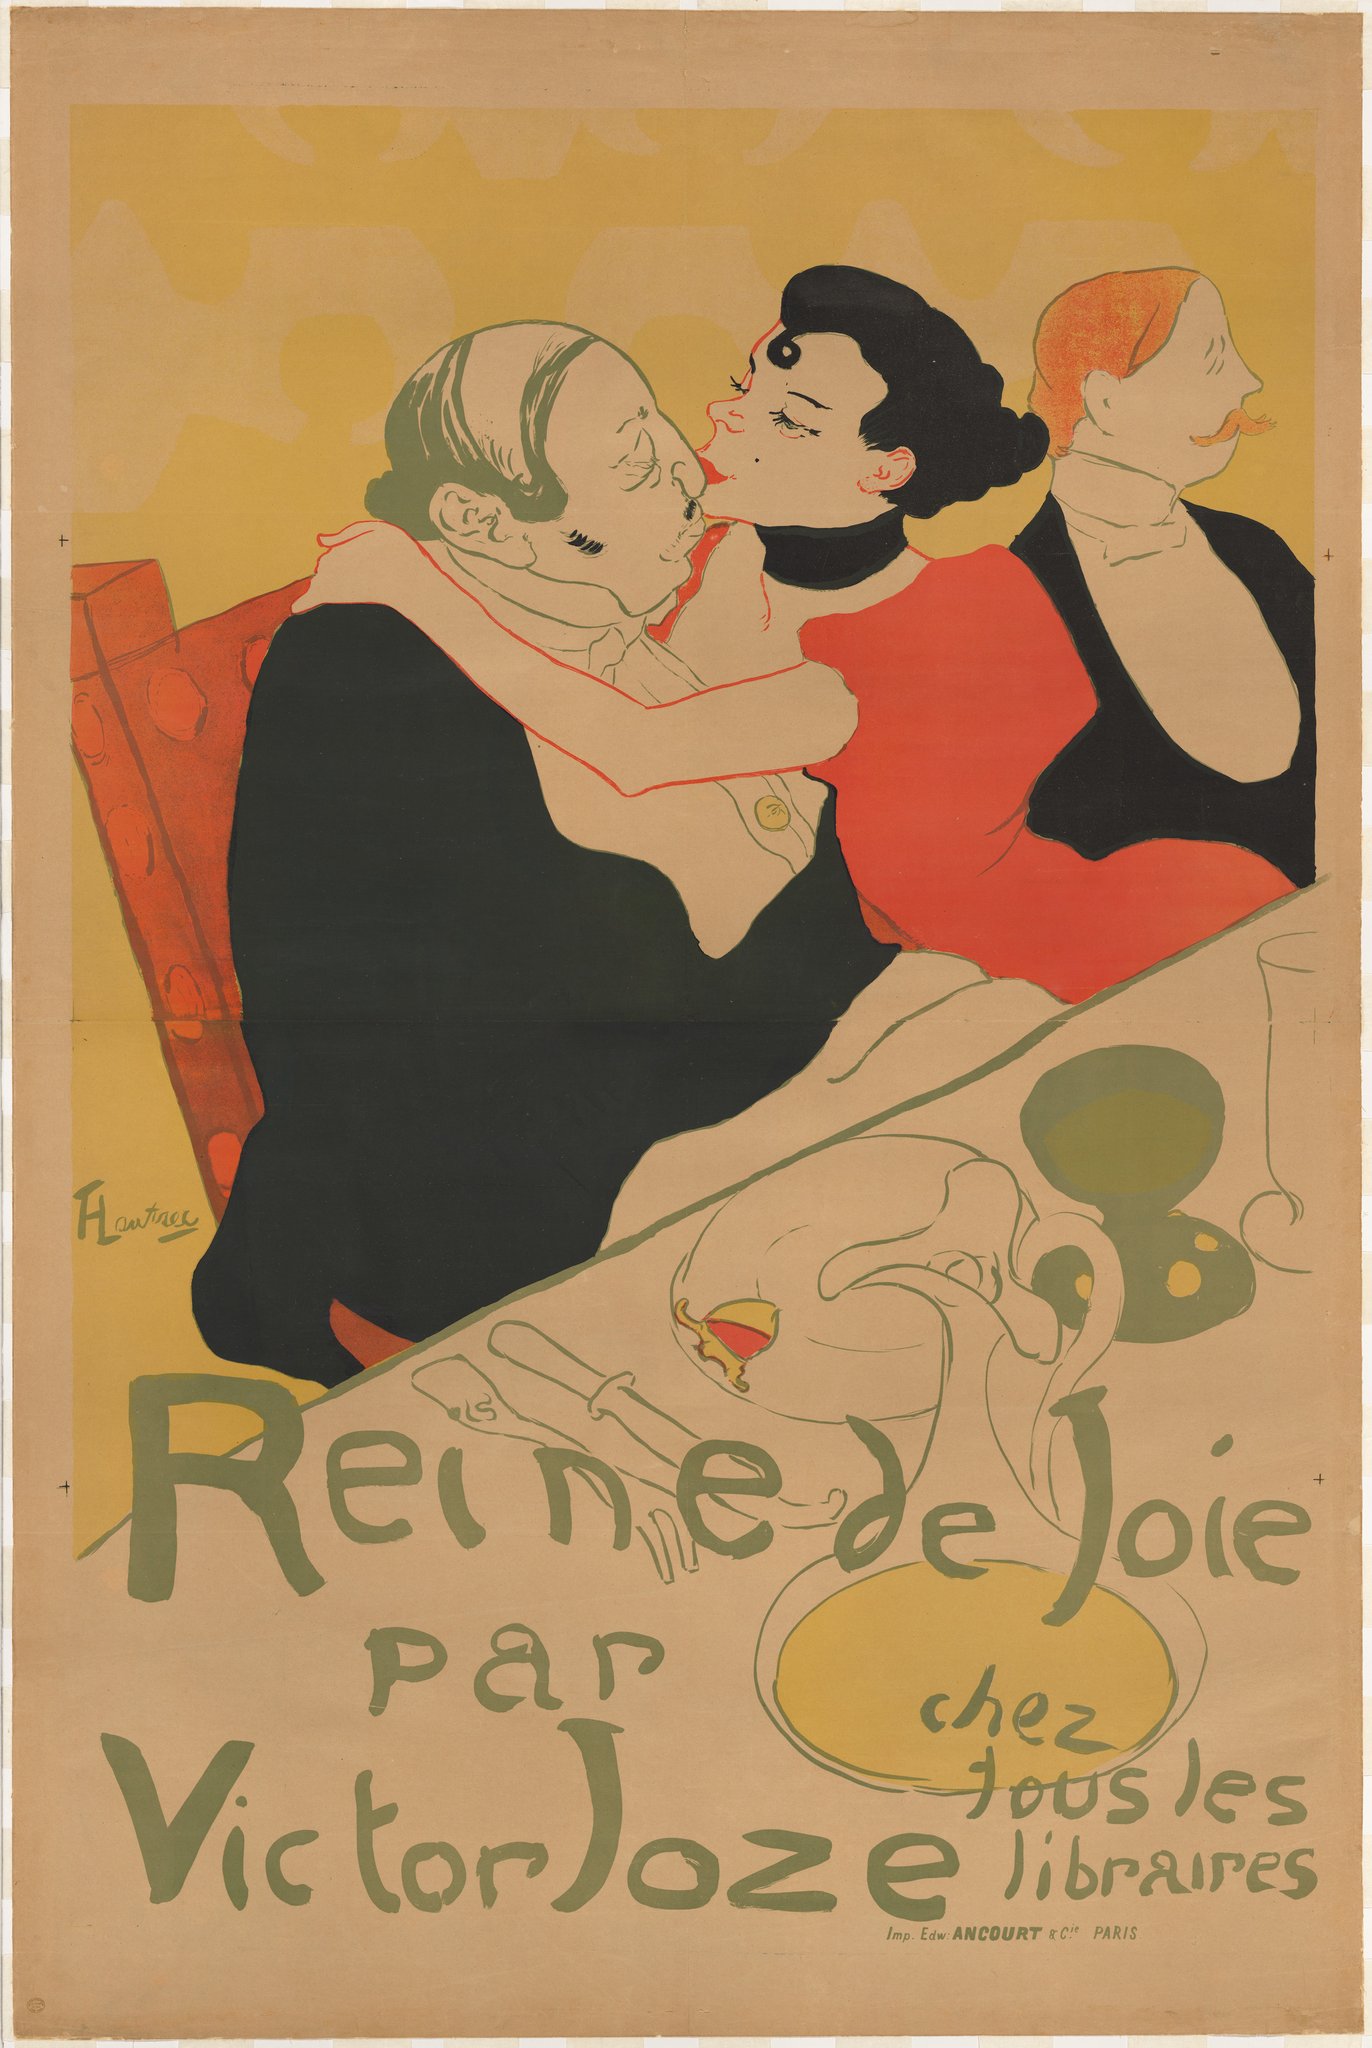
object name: poster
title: Reine De Joie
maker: henri de toulouse-lautrec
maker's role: artist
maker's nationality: french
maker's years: 1864-1901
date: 1892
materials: paper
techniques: lithograph, printing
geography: france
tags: men,women